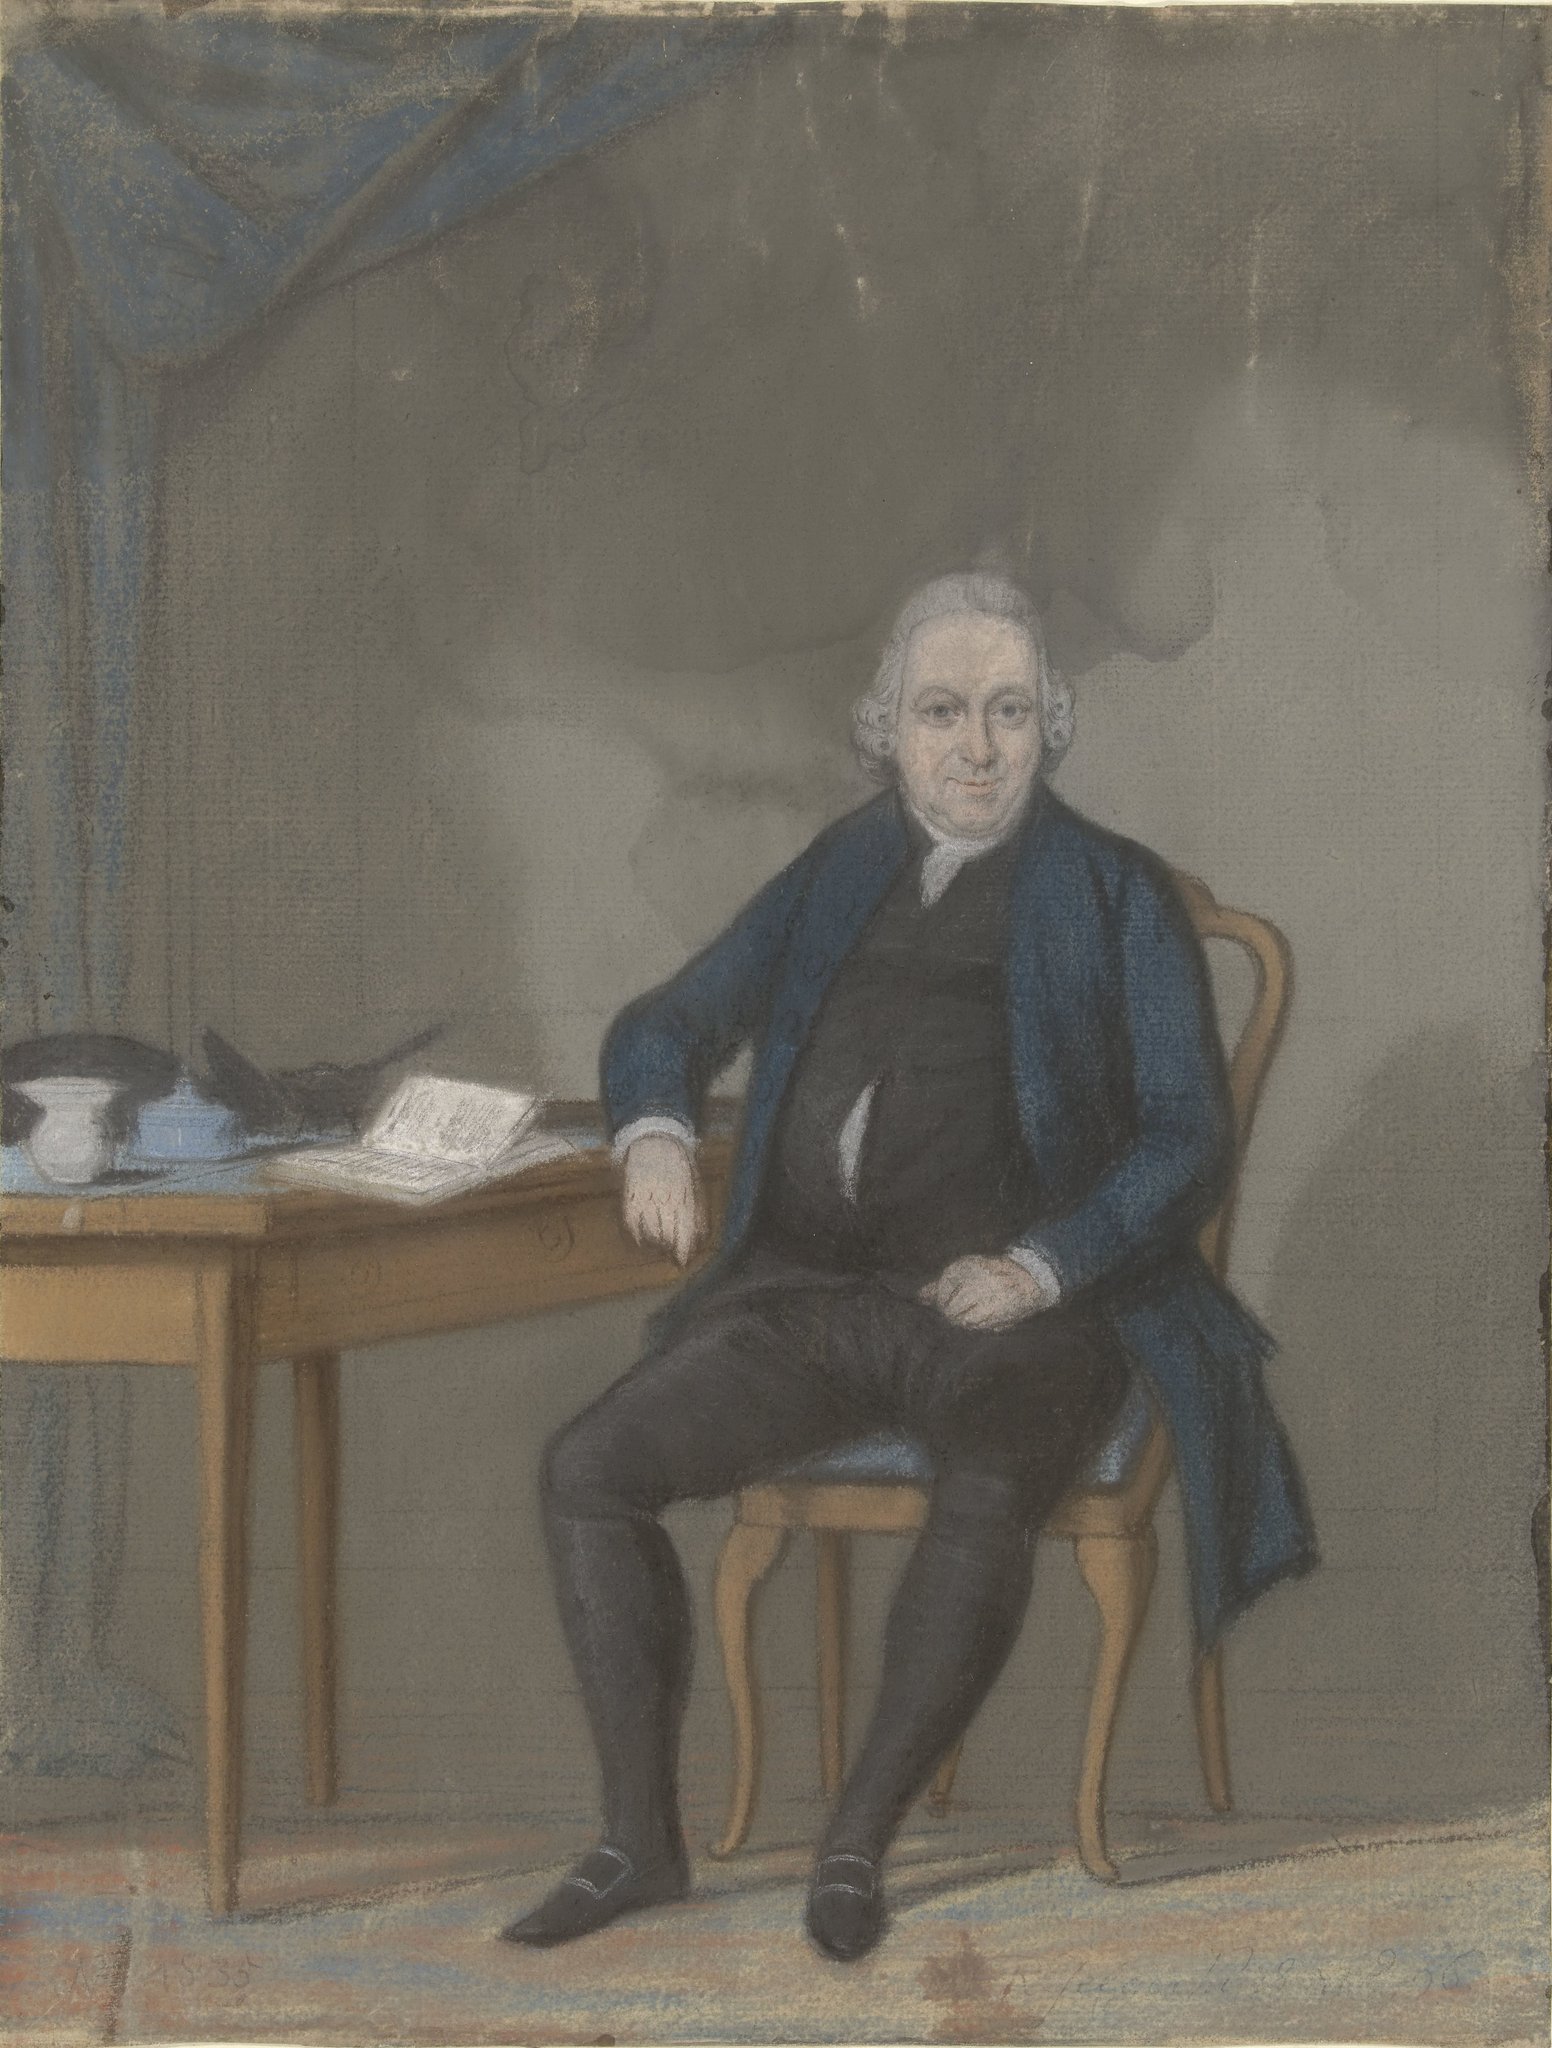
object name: drawing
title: Portret van Pieter van Lockhorst, zittend aan een tafel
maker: rienk jelgerhuis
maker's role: draughtsman, print maker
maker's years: 1729-1806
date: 1796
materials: paper, pastel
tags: historical persons